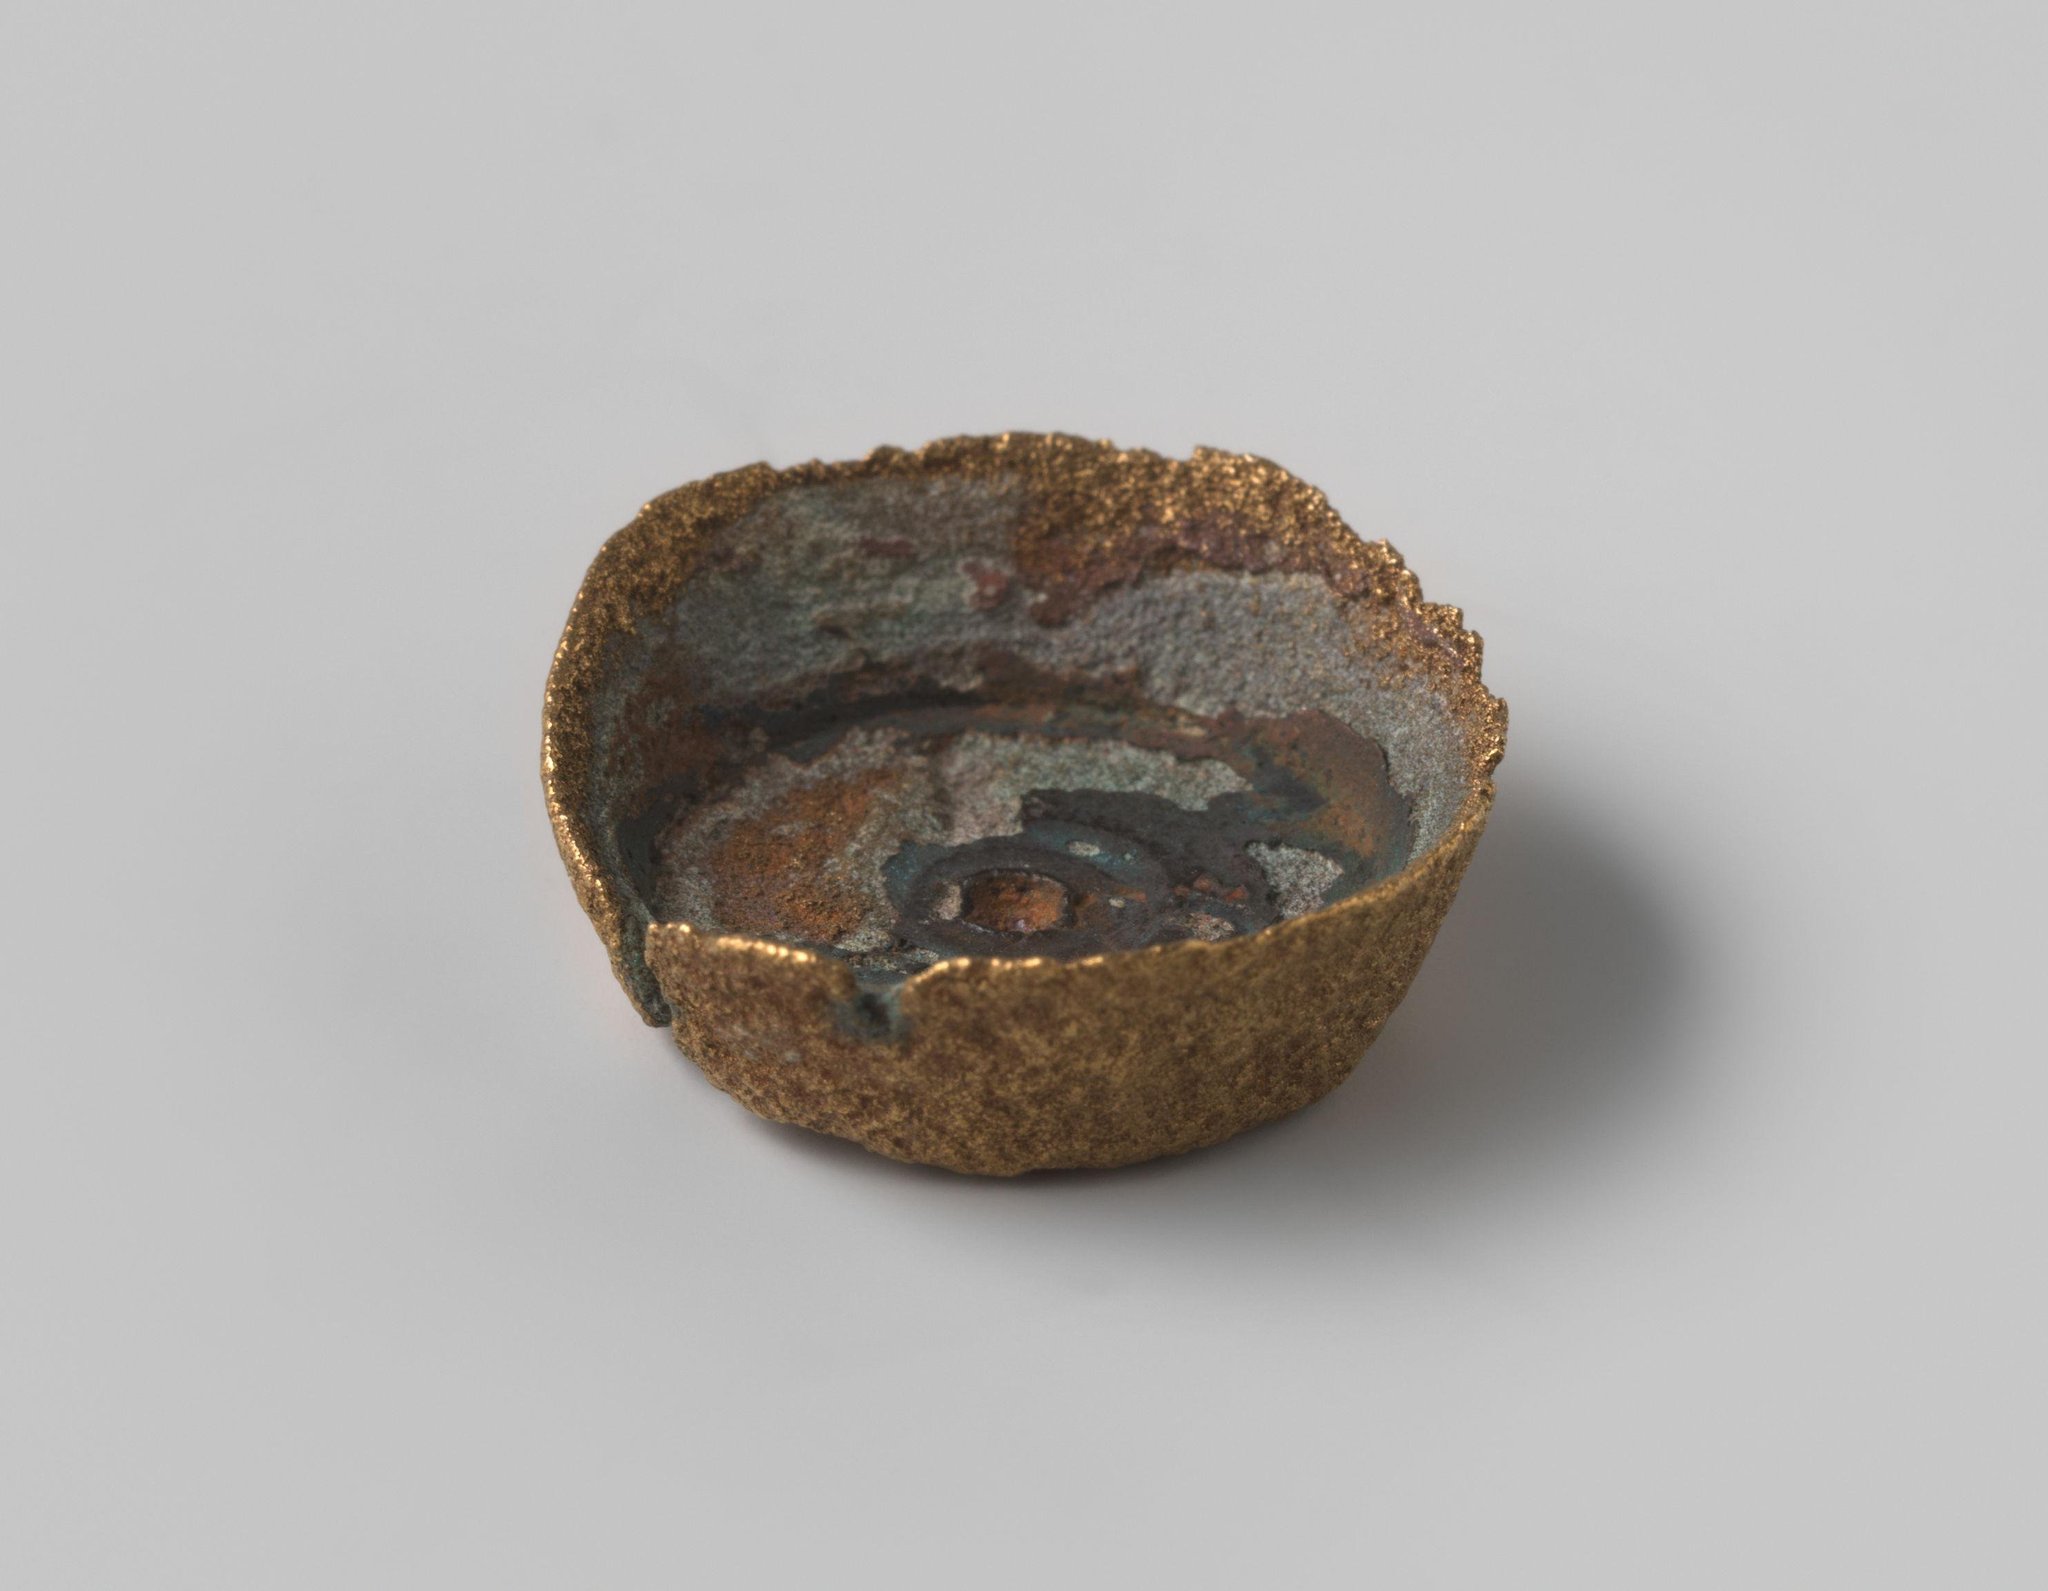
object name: sluitgewicht, pijlgewicht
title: Gewicht van sluitgewicht uit het wrak van de Oost-Indiëvaarder Hollandia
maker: Anonymous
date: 1700-1743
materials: copper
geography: netherlands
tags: verenigde oostindische compagnie, hollandia (schip), annet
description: Weight, cupweight, cup; fragment of cup, id. NG 1980-27H2775, id. marks.